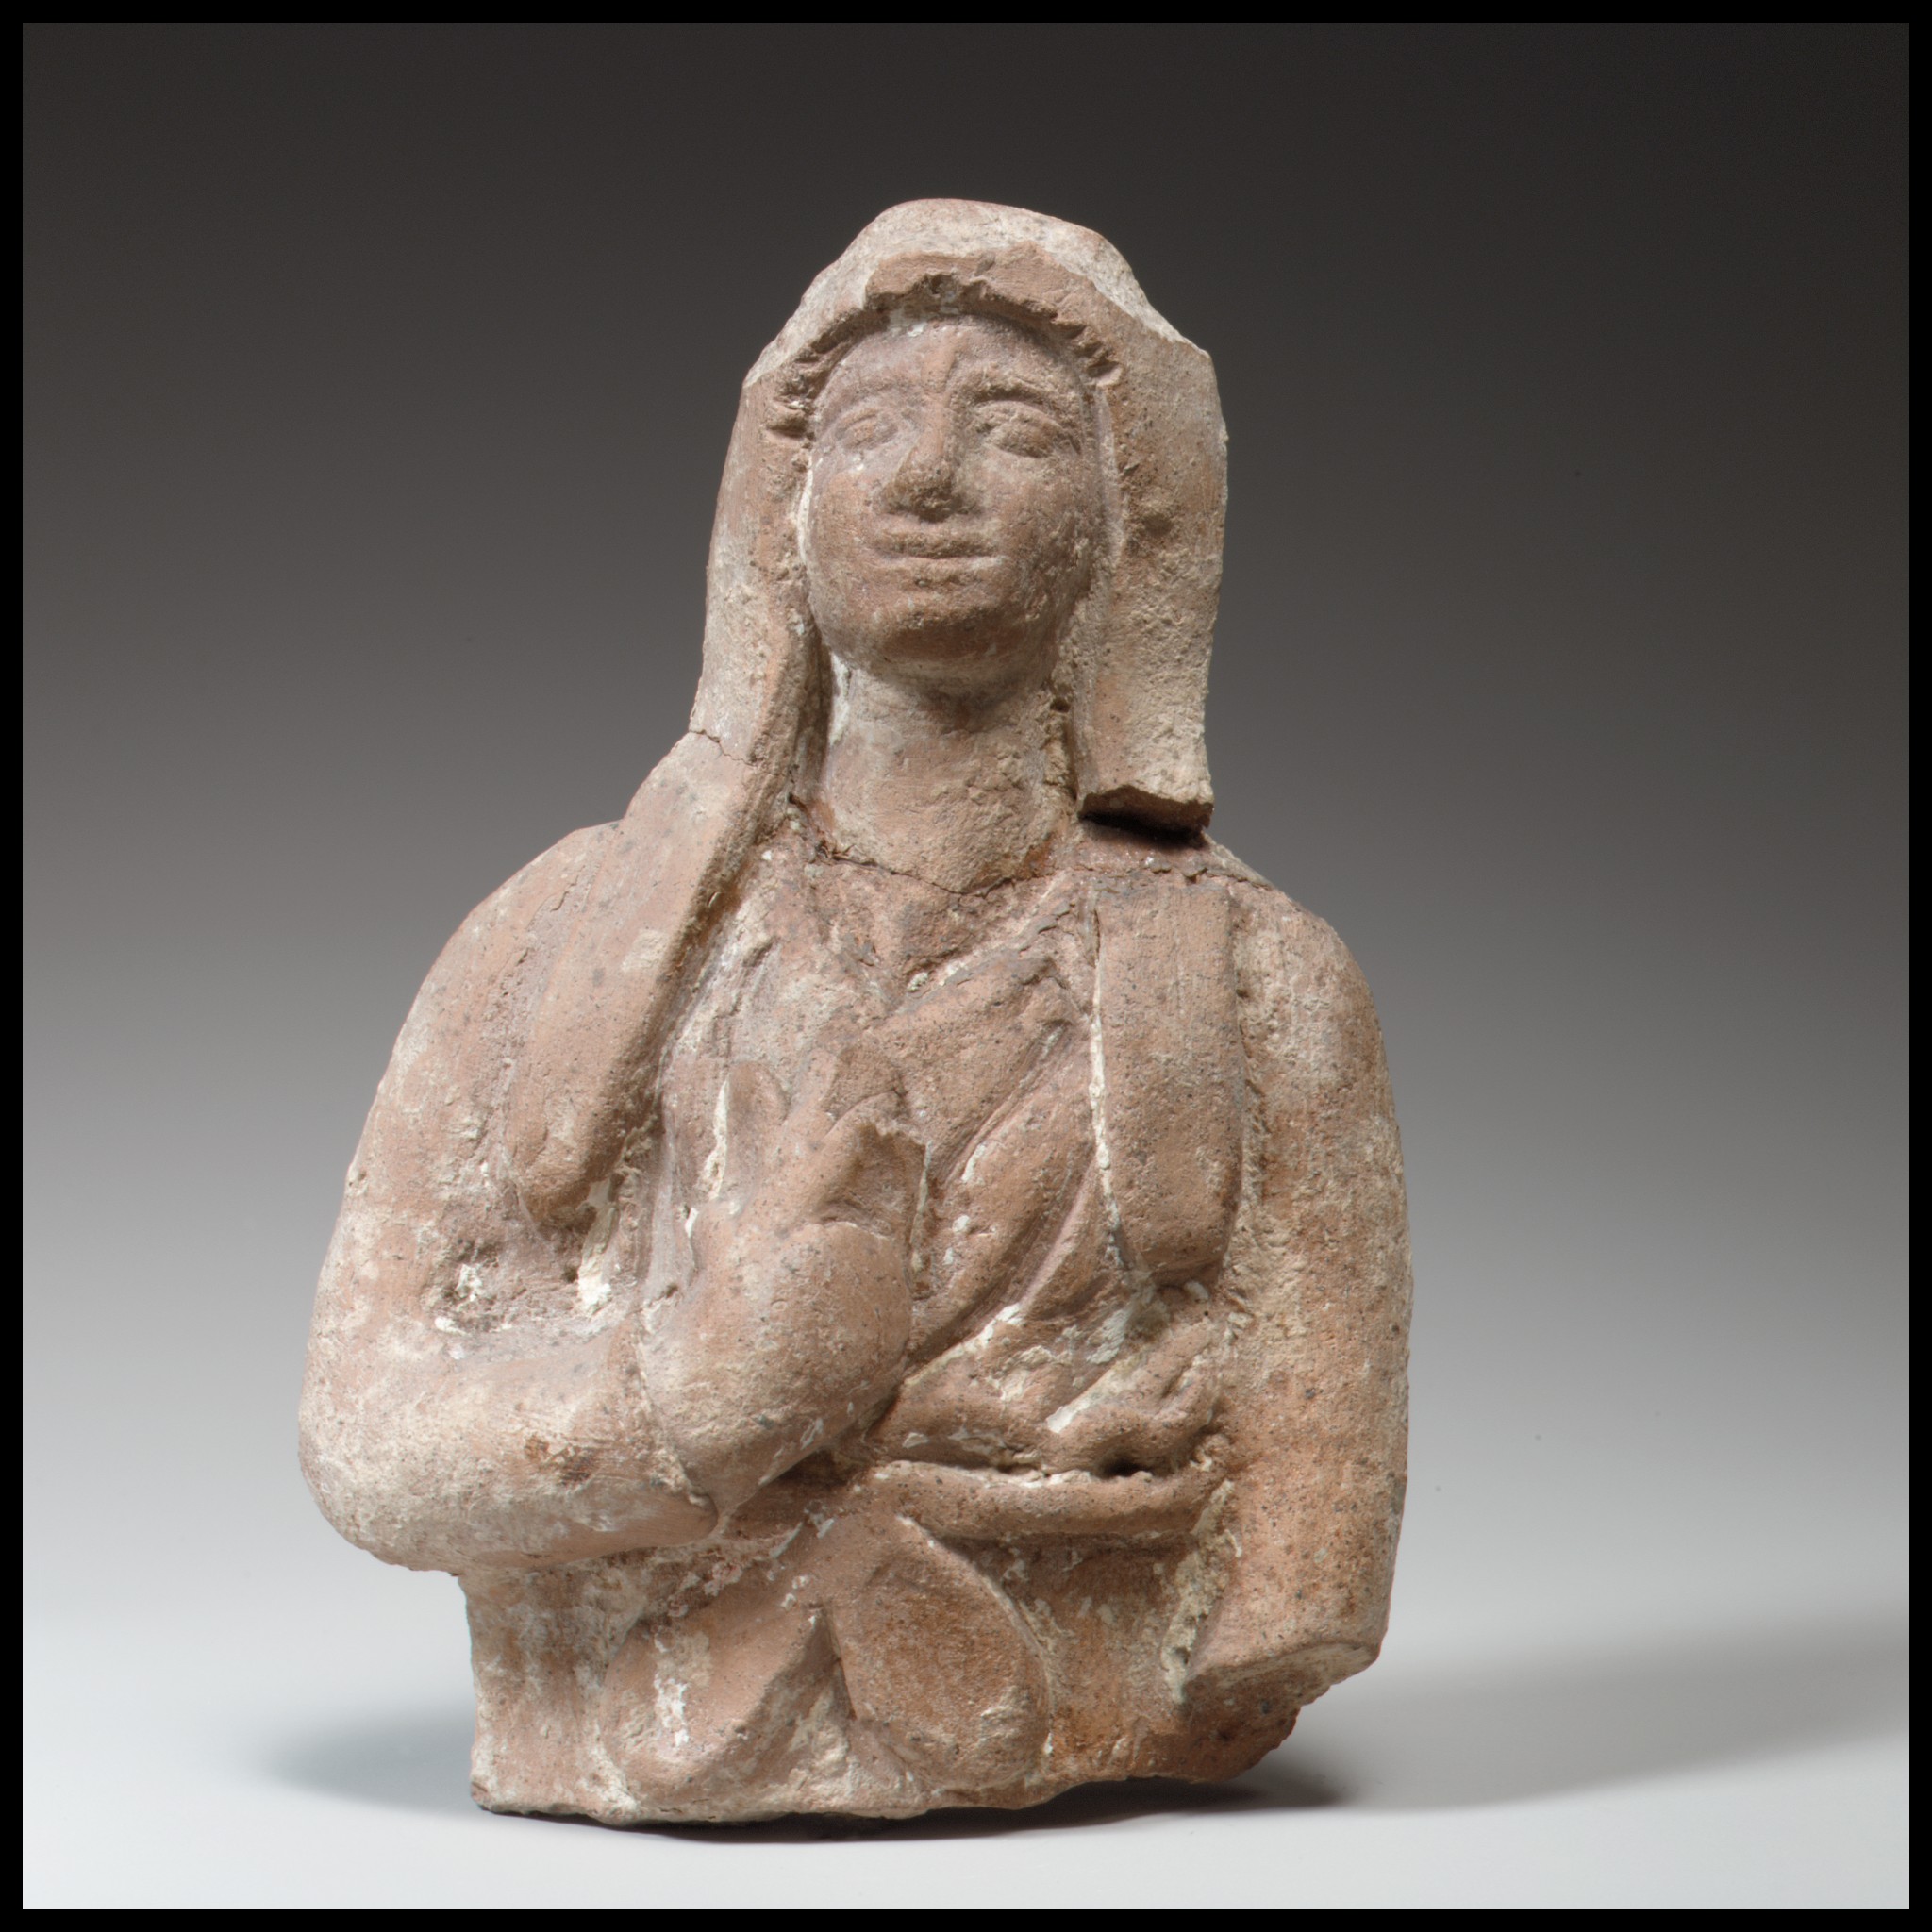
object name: statuette of a woman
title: Female grotesque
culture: cypriot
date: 200-1 BCE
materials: terracotta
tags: women